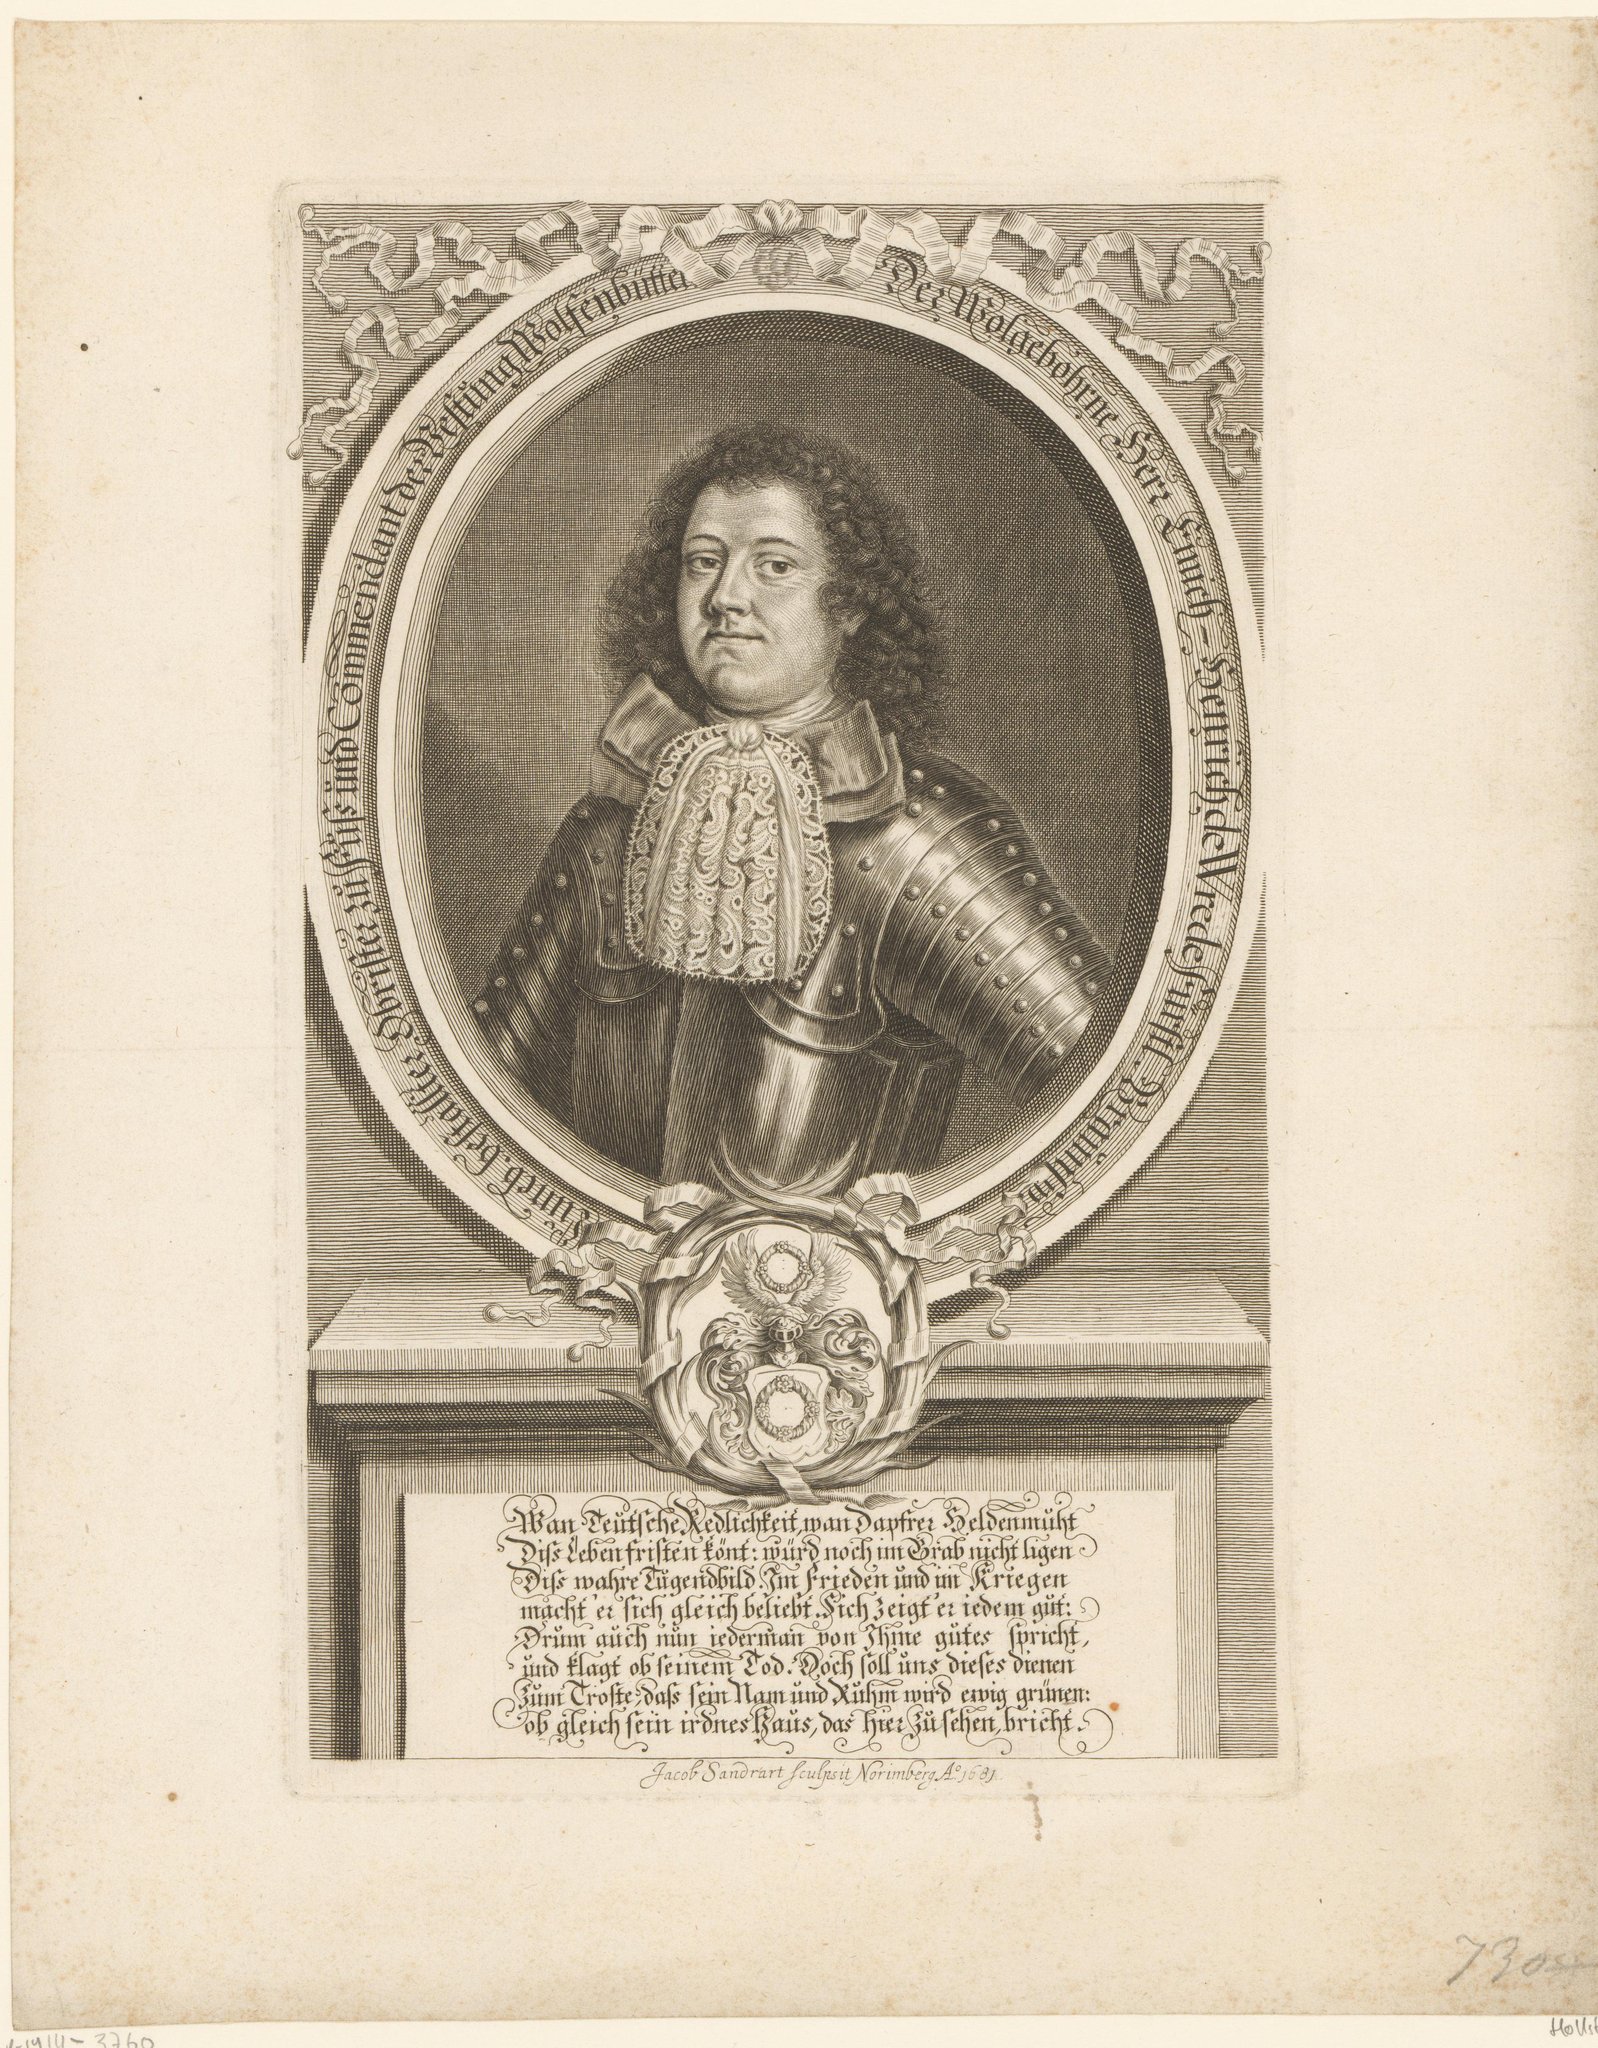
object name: print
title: Portret van Emich Henrich von Wrede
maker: jakob von sandrart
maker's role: print maker, publisher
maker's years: 1630-1708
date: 1681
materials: paper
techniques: engraving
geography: nuremberg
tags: commander-in-chief, general, marshal, armour, historical persons, armorial bearing, heraldry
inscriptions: collector's mark: Lugt 2228